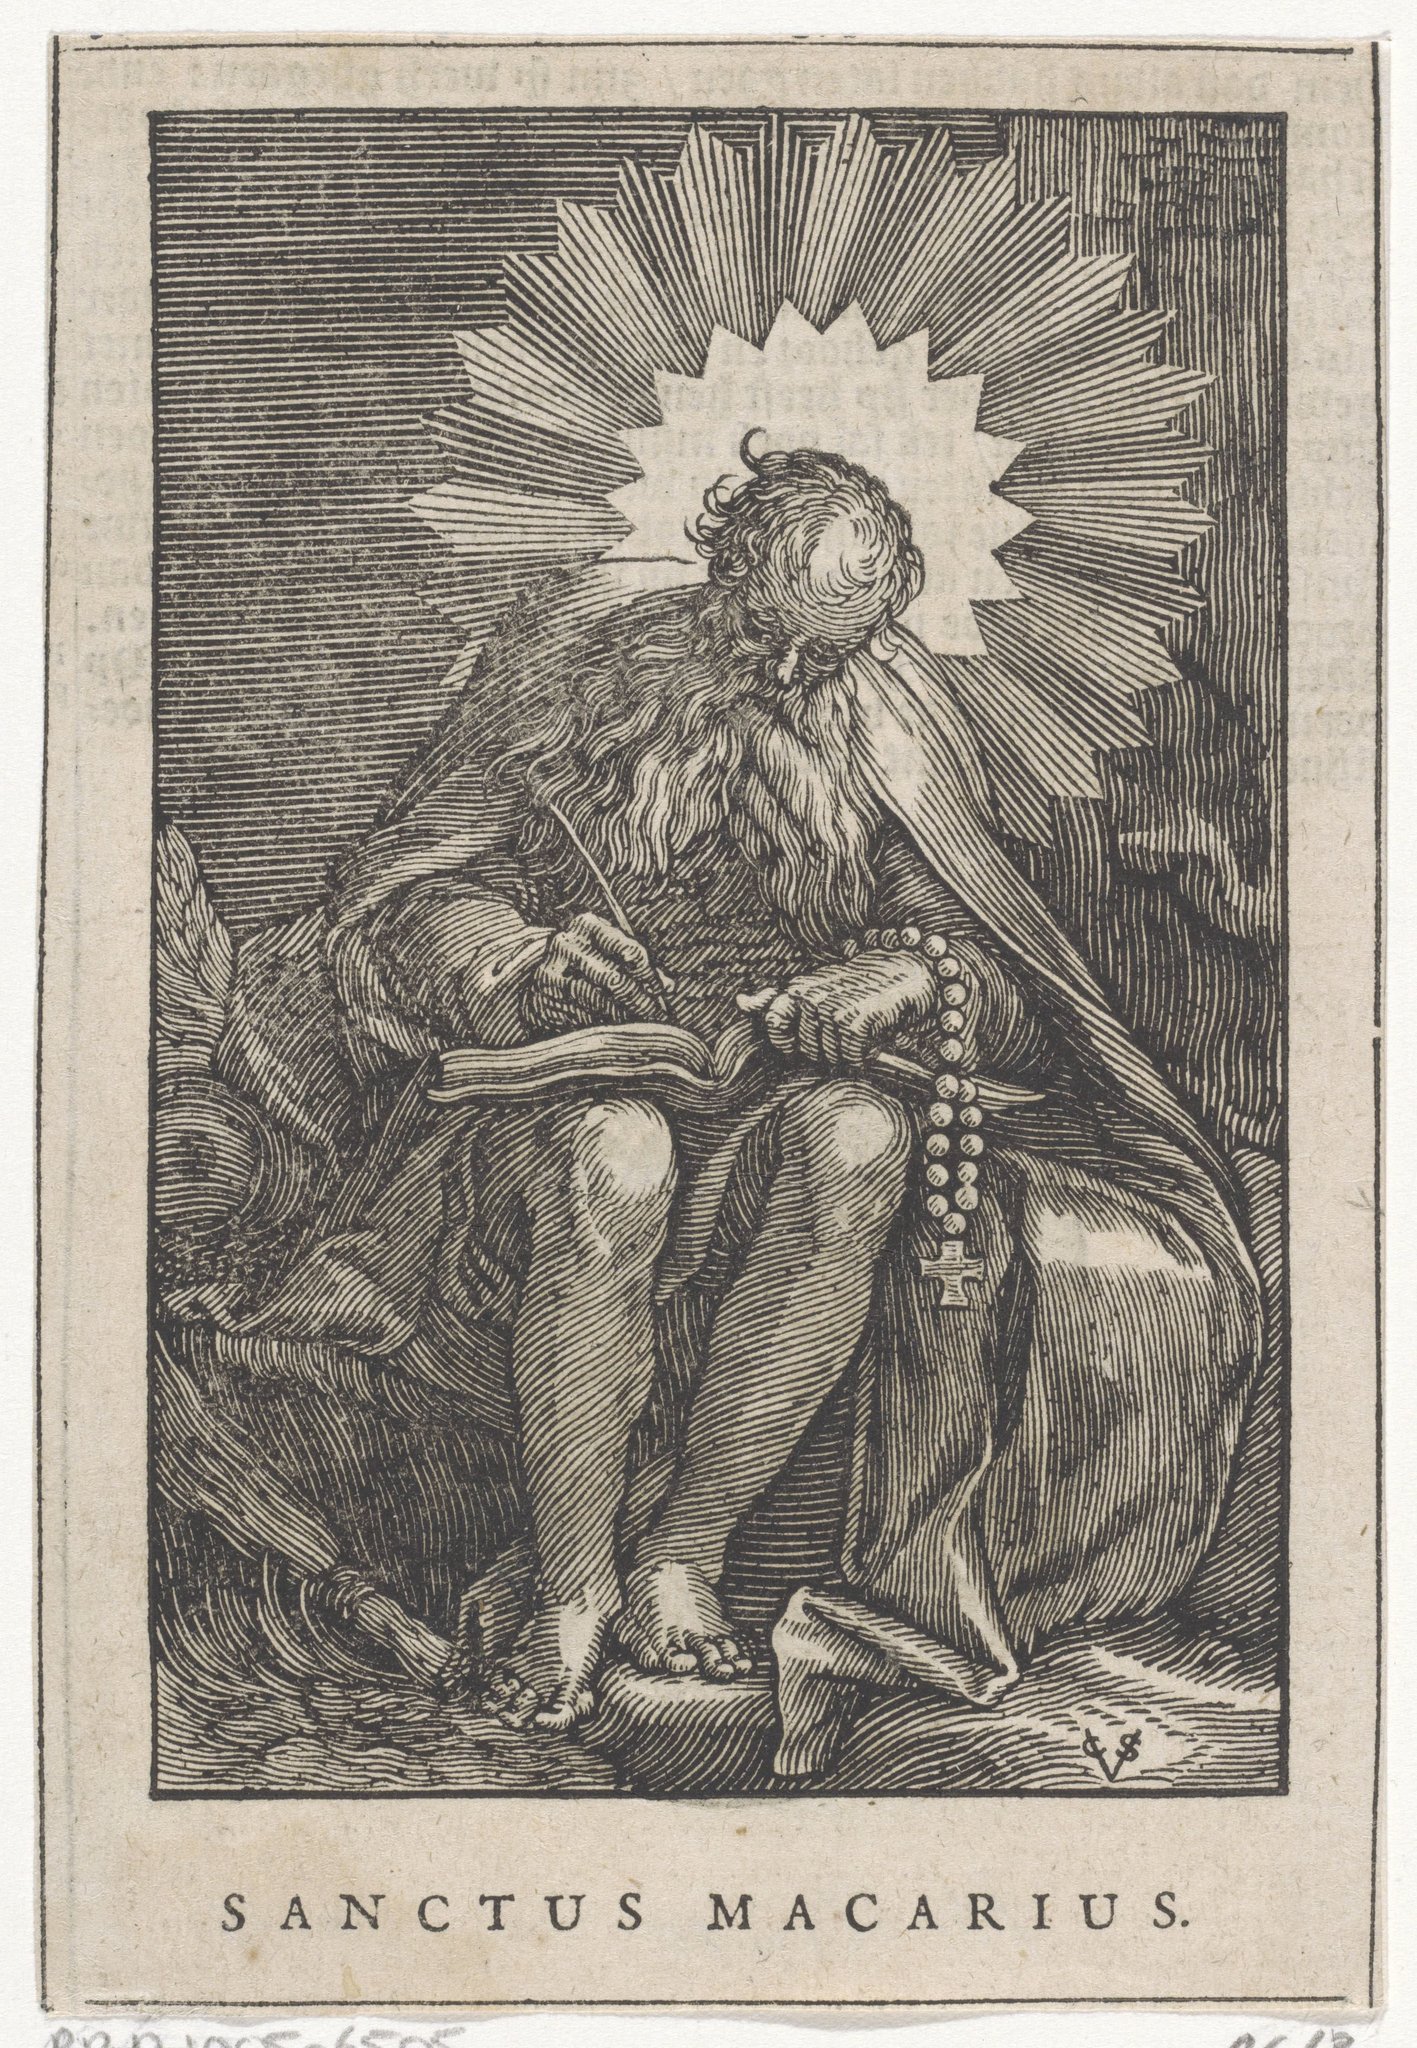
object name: print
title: Heilige Macarius als kluizenaar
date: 1644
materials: paper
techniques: letterpress printing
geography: amsterdam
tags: anchorite, hermit, the hermit macarius of egypt (the elder, the great); possible attributes: t-shaped staff, skull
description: Prent uit: Rosweyde, Heribert. 'tBosch der eremyten ende eremitinnen, van Aegypten ende Palestinen. Amsterdam: Pieter Jacobsz. Paets, 1644.